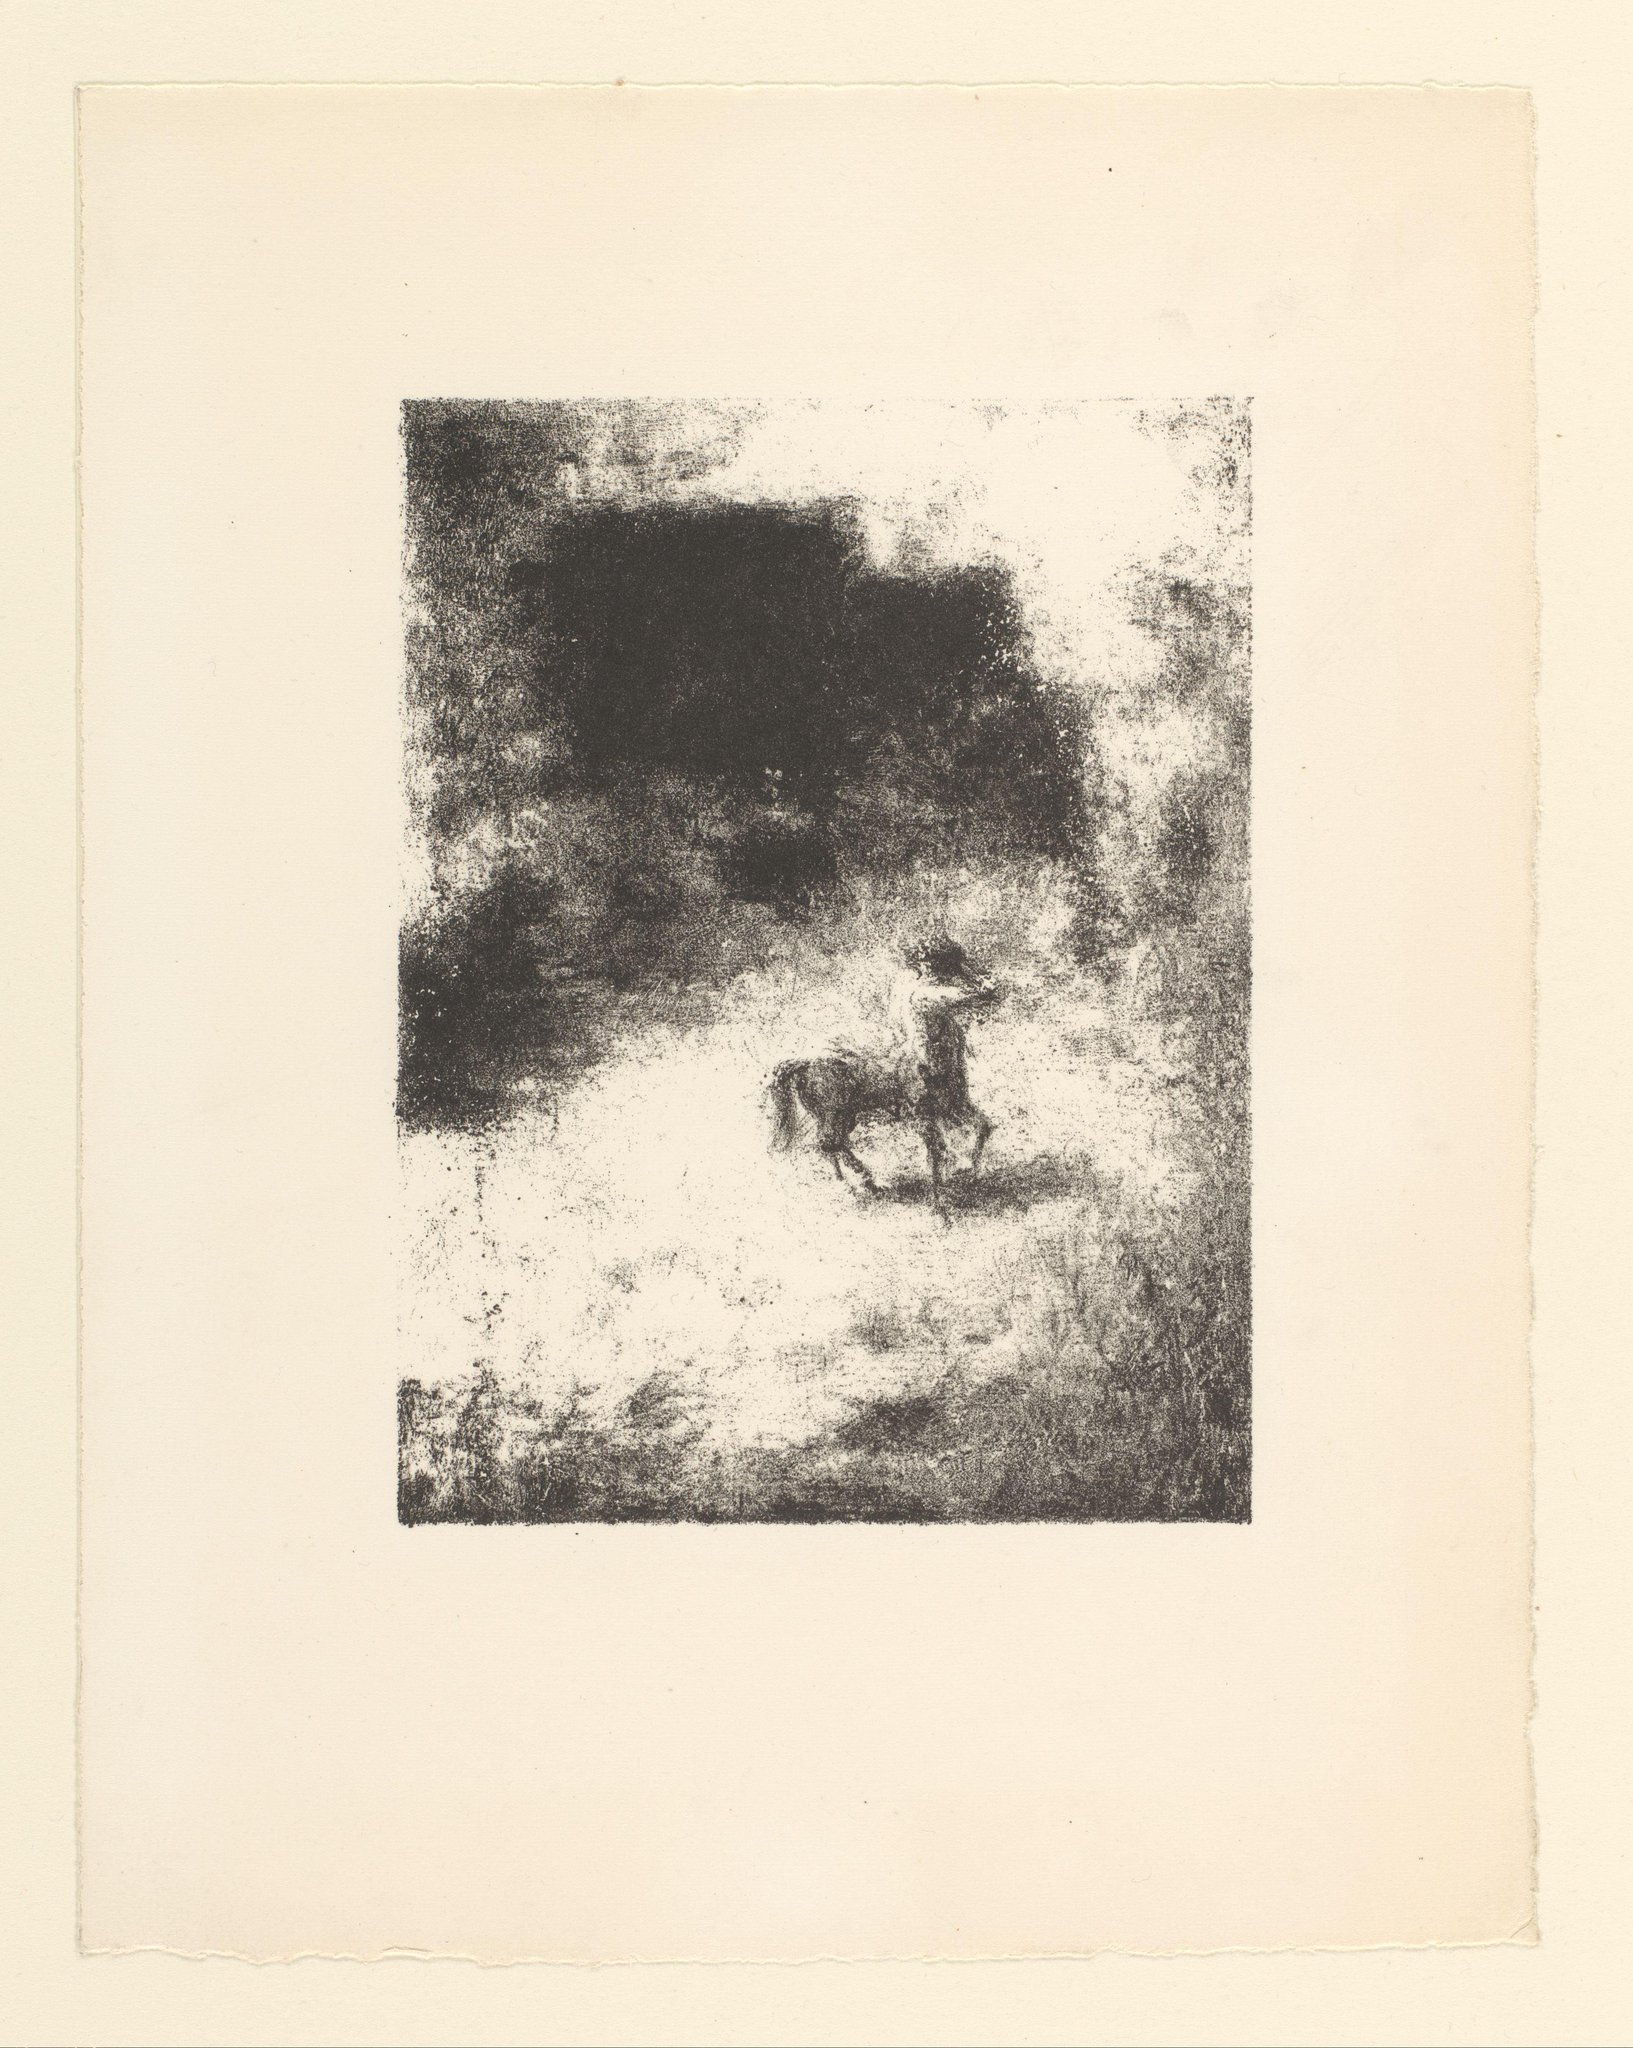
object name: print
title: Centaur op open plaats in het bos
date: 1920-1935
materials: paper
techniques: lithograph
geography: paris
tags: centaurs, forest, wood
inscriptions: collector's mark: Lugt 2228, collector's mark: Lugt 2760